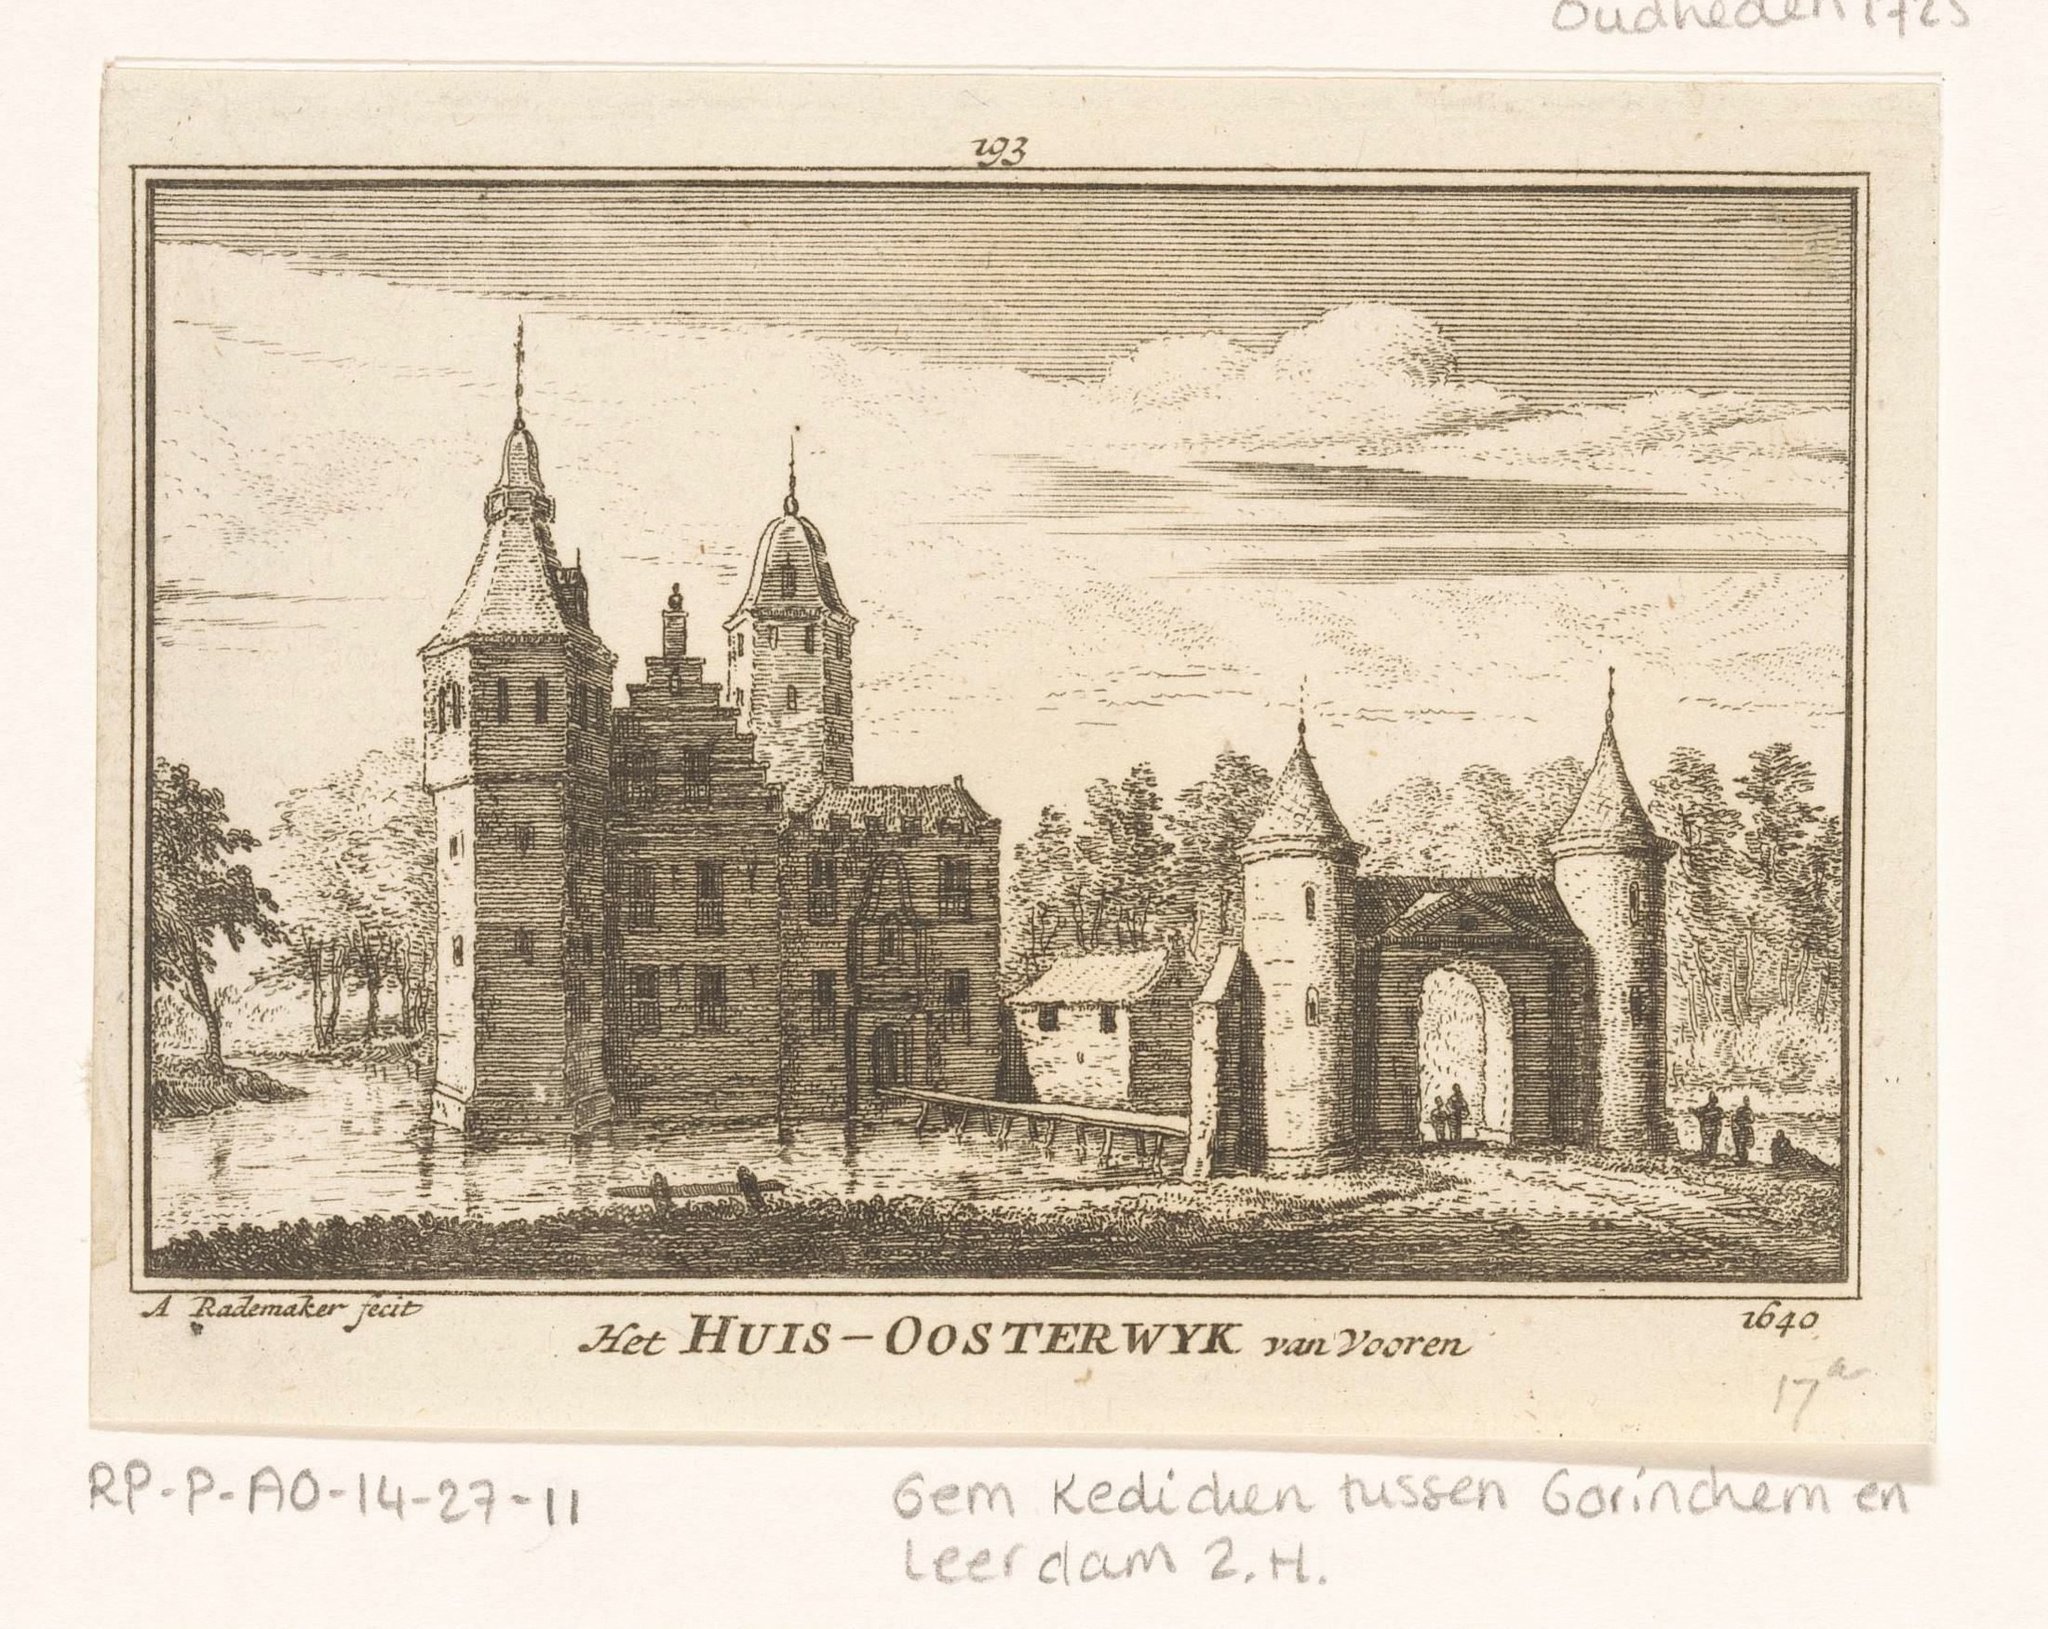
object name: book illustration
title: Gezicht op Huis Oosterwijk, 1640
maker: abraham rademaker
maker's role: draughtsman, print maker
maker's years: 1676-1735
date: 1725-1803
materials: paper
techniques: engraving, etching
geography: amsterdam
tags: castle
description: Prent ook gebruikt in: Rademaker, Abraham. Kabinet van Nederlandsche outheden en gezichten: vervat in 300 konstplaaten (…). 2 delen. Amsterdam: Willem Barents, 1725, dl. 2, ill. 193. Na 1725 is deze prent nog in verschillende heruitgaven verschenen, uitgegeven in 1727-1733, 1770-1771 en 1792-1803. Uit welke uitgave het huidige exemplaar precies komt is niet na te gaan.